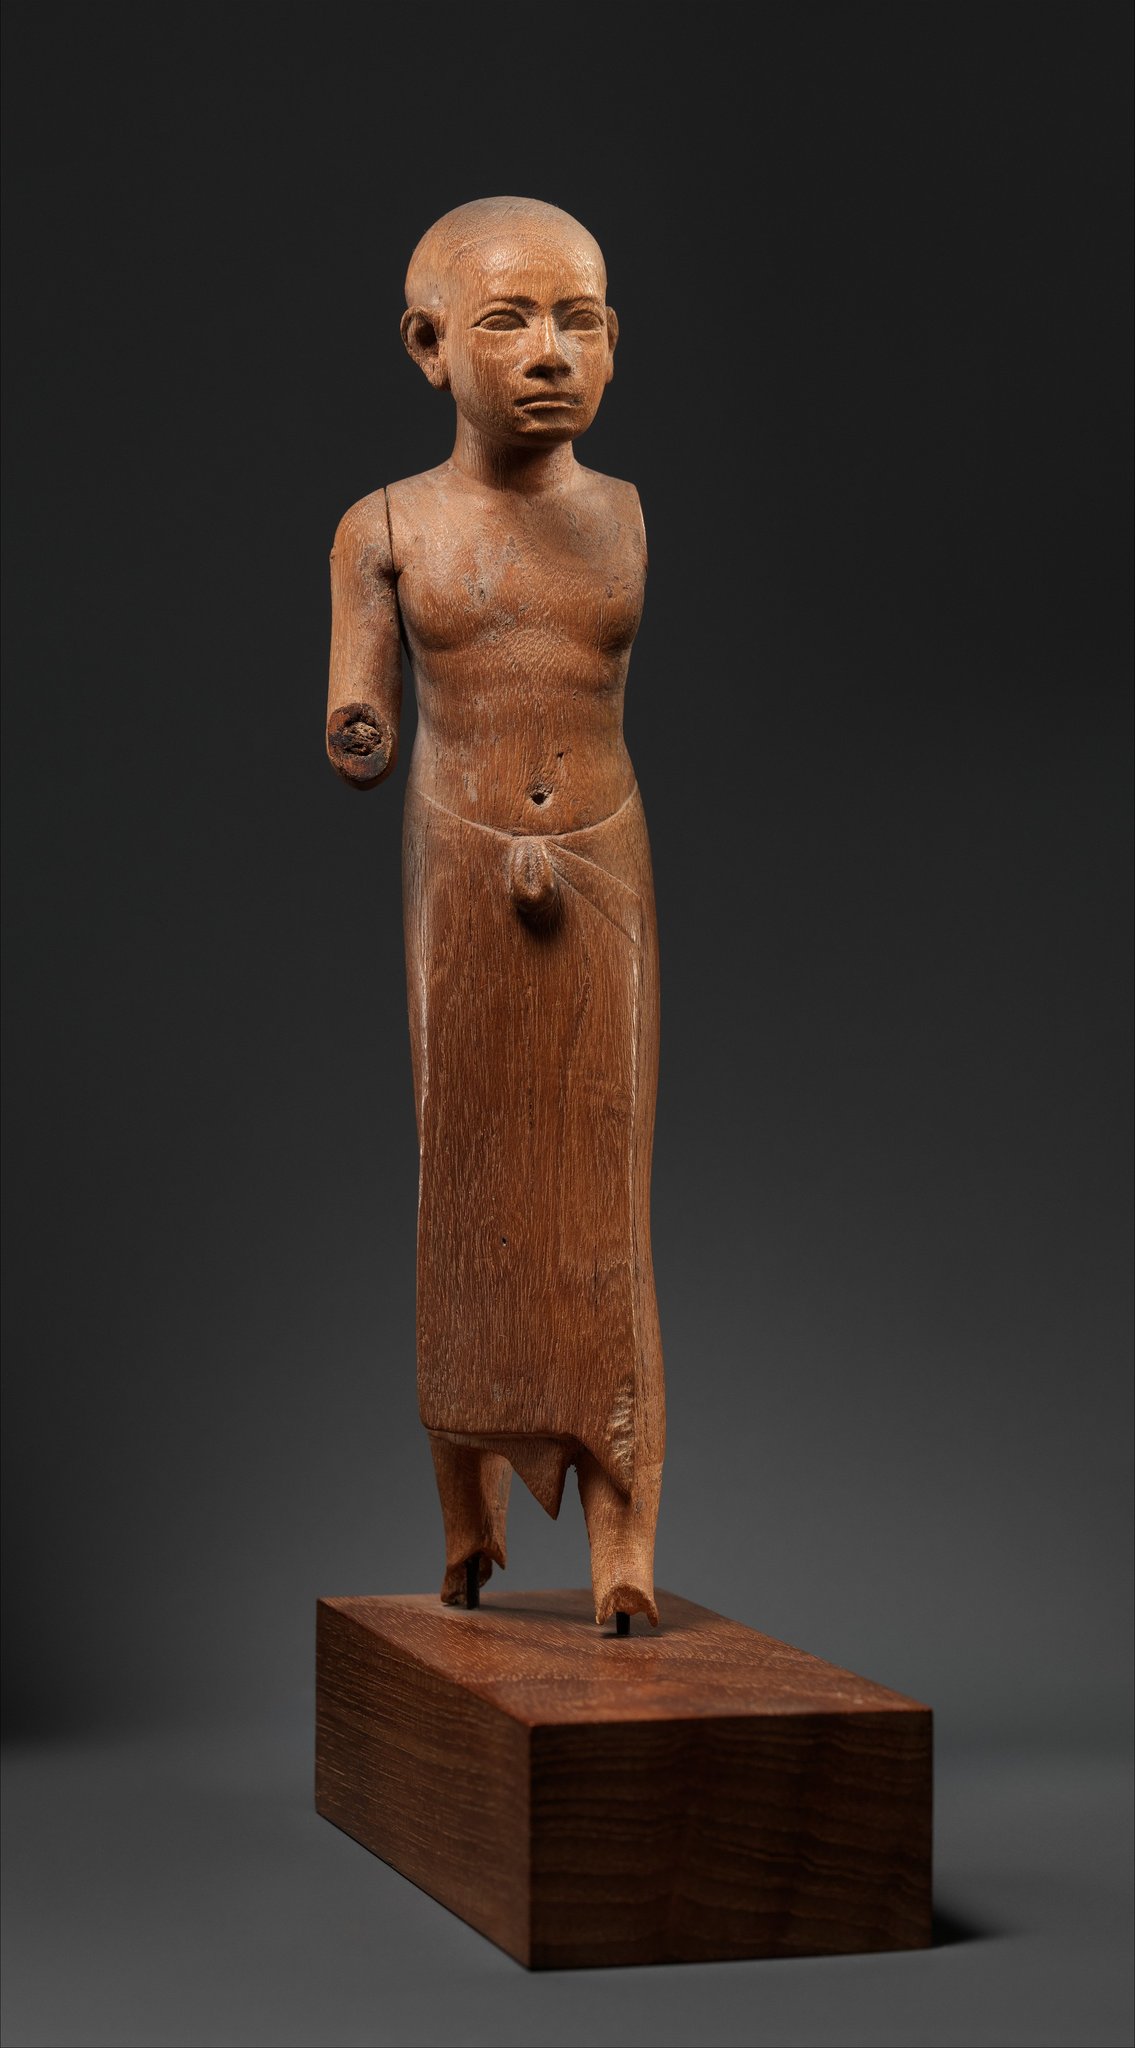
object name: figure of a striding man in a long kilt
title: Figure of a Striding Man with a Long Kilt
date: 1978-1940 BCE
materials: wood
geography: egypt